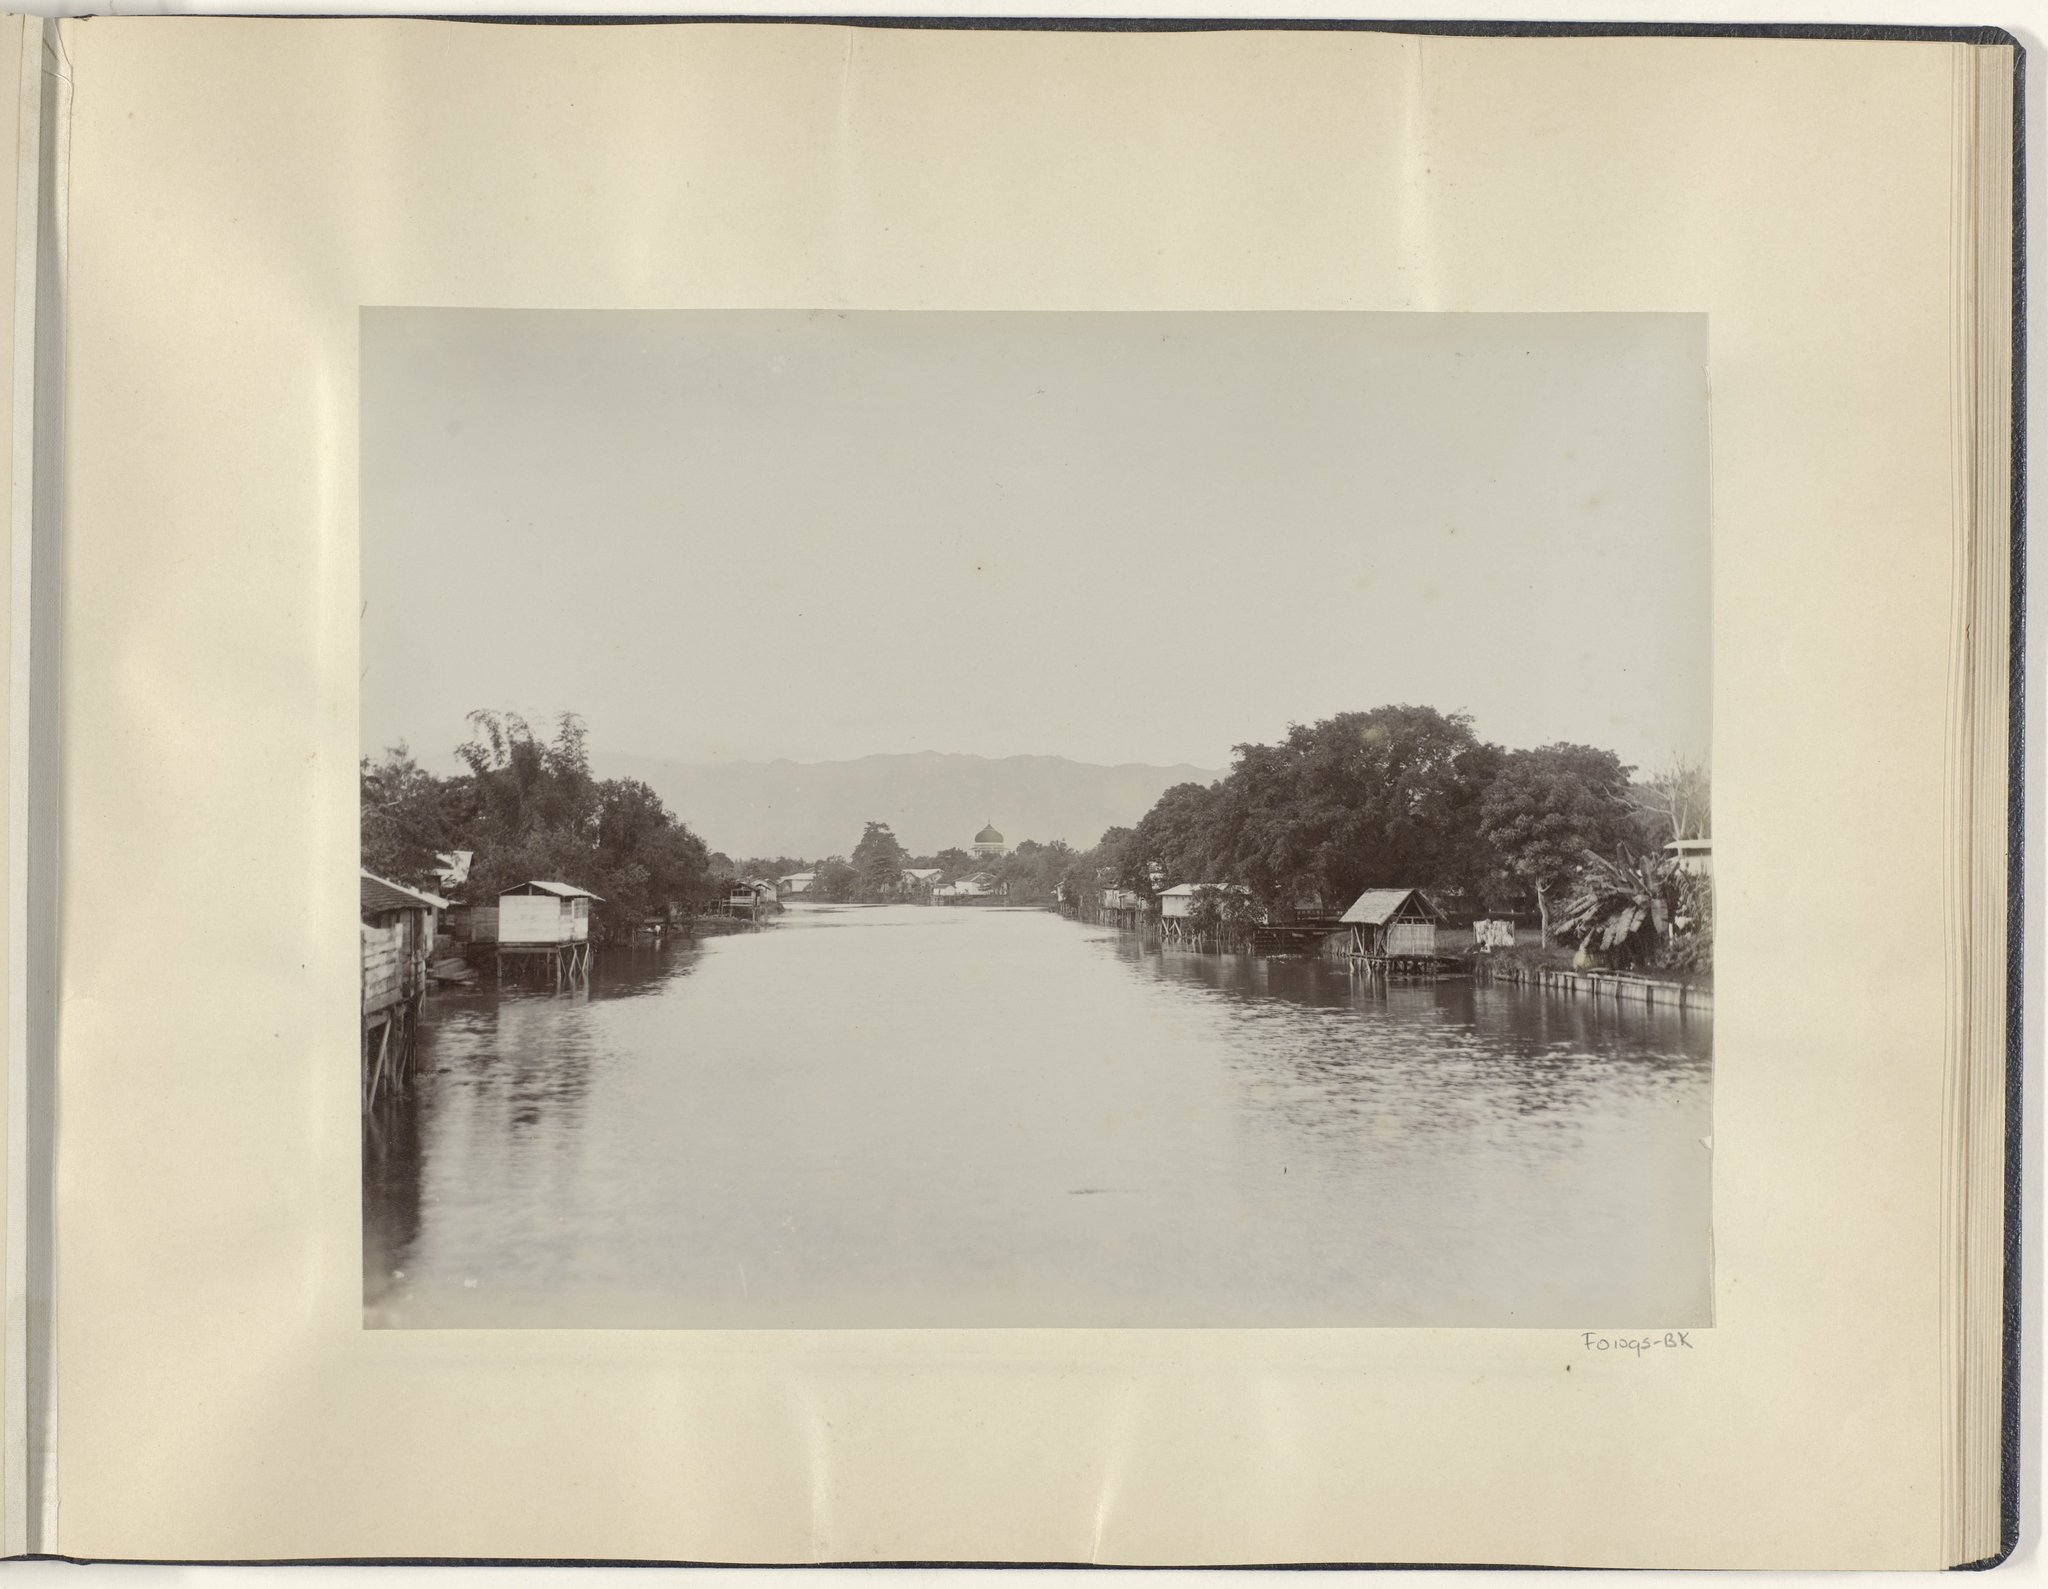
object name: photograph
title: Rivier met paalwoningen in Nederlands-Indië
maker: Anonymous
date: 1895-1905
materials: paper, photographic support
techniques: albumen print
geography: dutch east indies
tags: river (+ landscape with figures, staffage), dutch east indies, the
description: Onderdeel van Reisalbum met foto's van bezienswaardigheden in Italië, Zwitserland en Nederlands-Indië.